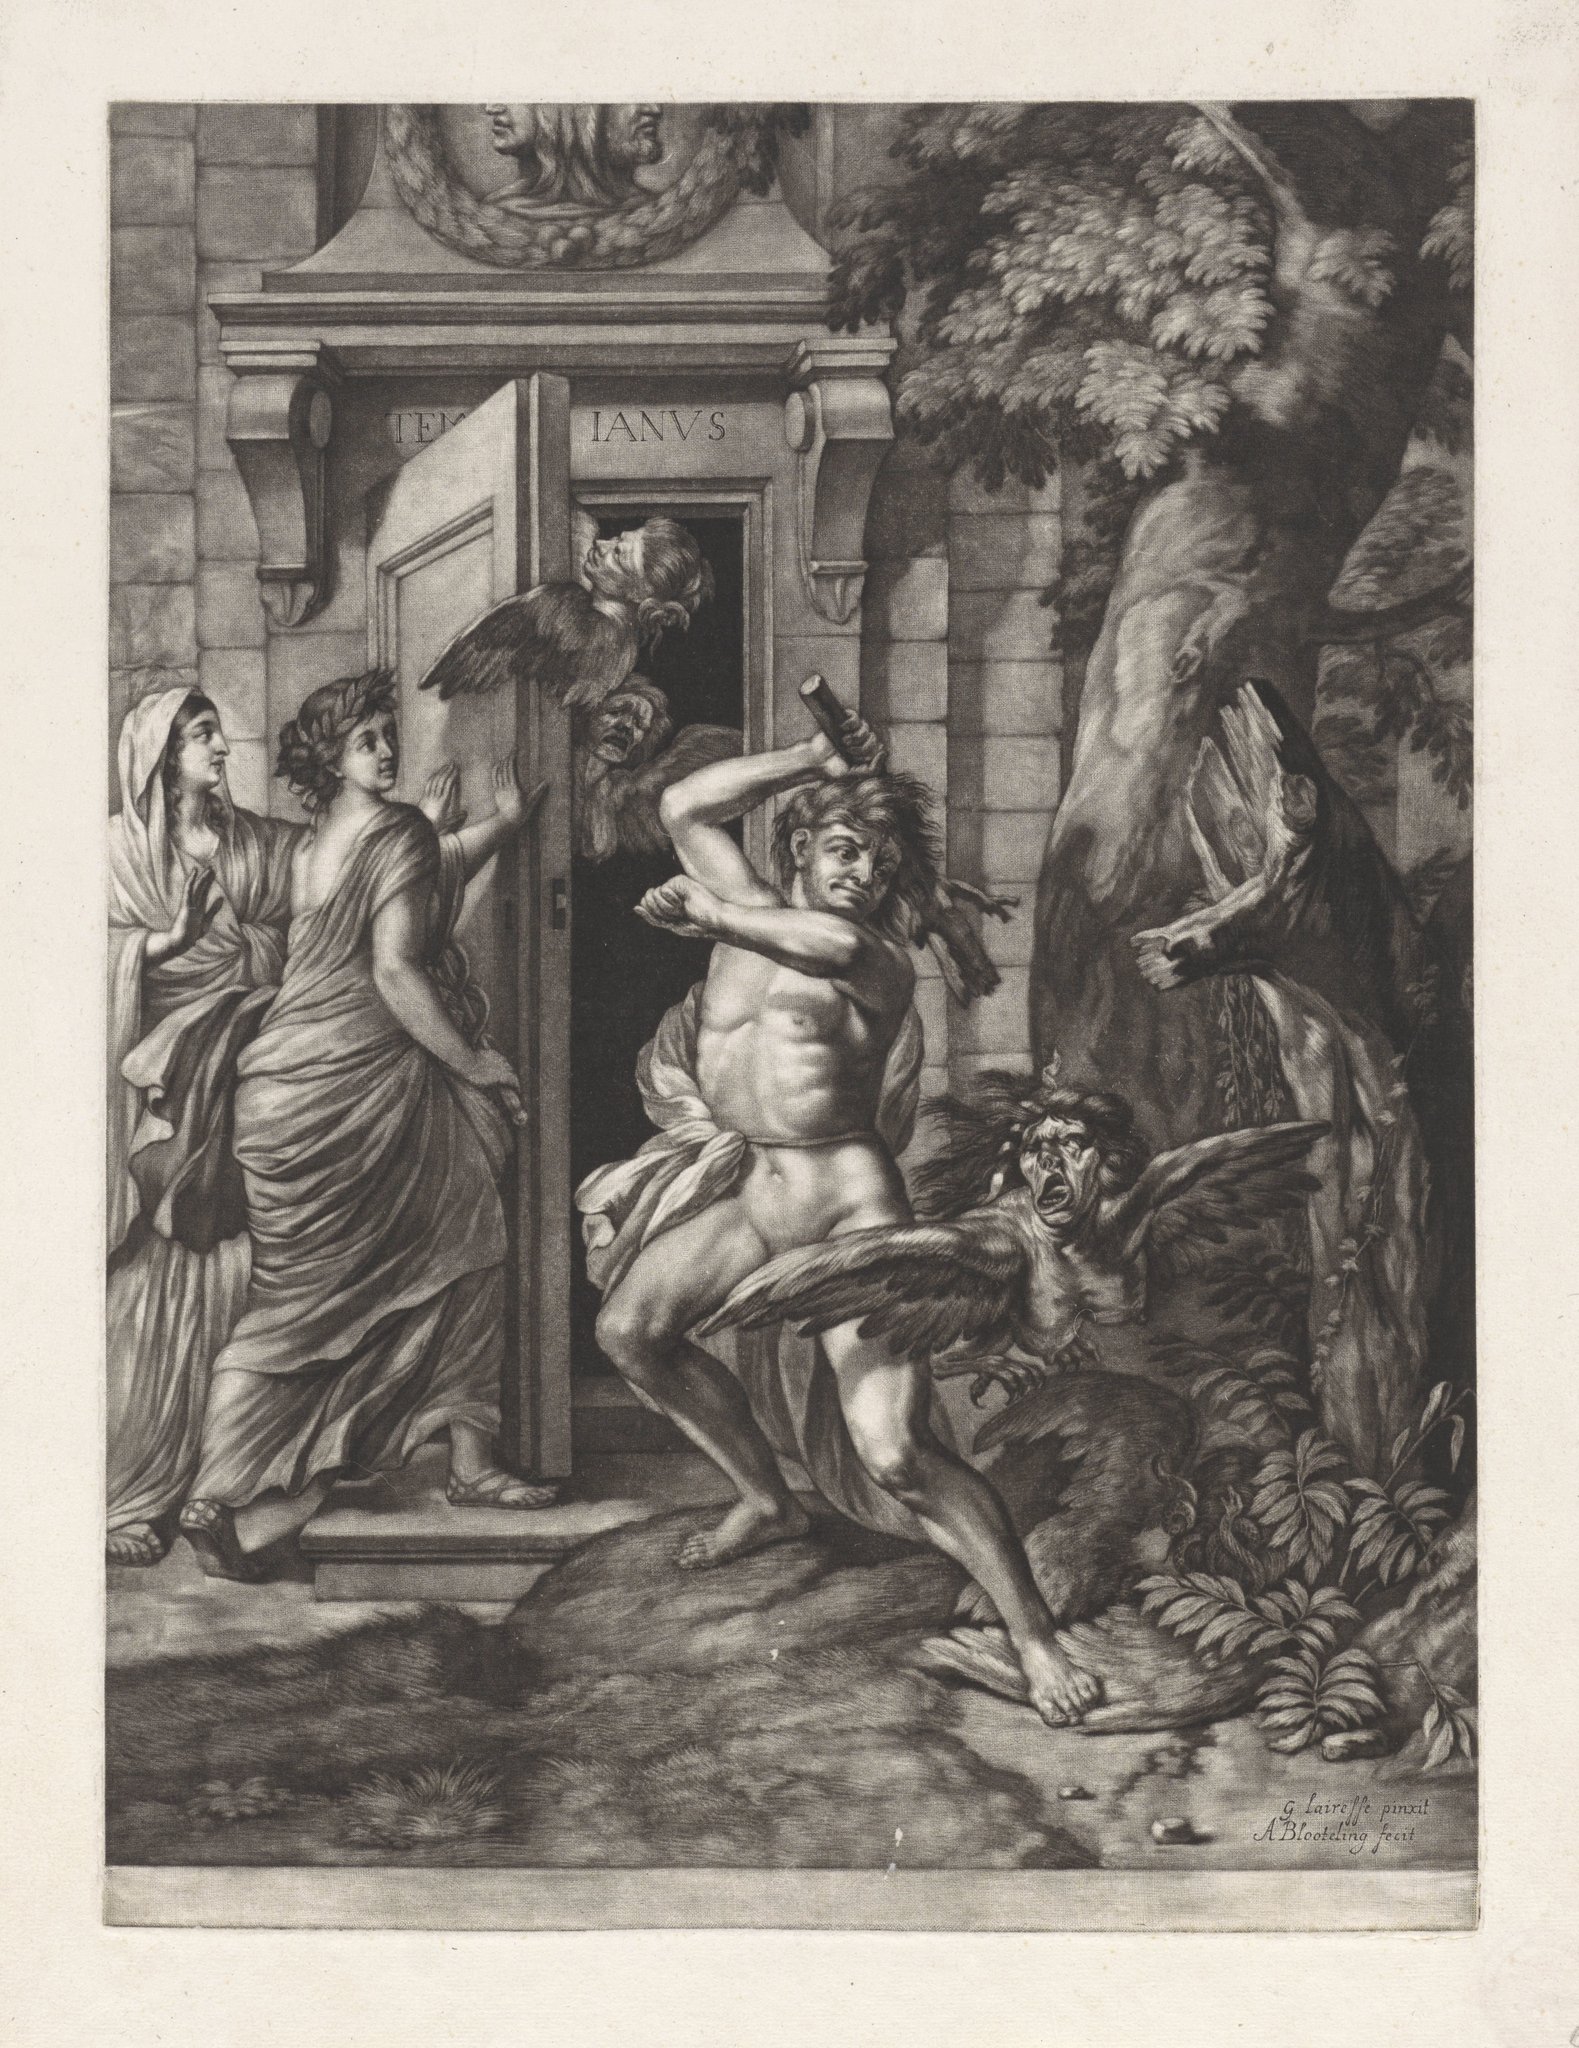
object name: print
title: Allegorie op de Vrede van Nijmegen (1678): Hercules verslaat de harpijen voor de tempel van Janus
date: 1678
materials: paper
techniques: engraving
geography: amsterdam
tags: (story of) hercules (heracles), temple, shrine ~ roman religion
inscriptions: collector's mark: Lugt 240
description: Allegorie op de Vrede van Nijmegen gesloten op 10 augustus 1678 tussen de Republiek en Frankrijk. Twee allegorische vrouwenfiguren (Vrede en Voorspoed?) sluiten de deur van de tempel van Janus, Hercules verslaat de harpijen met een knots.